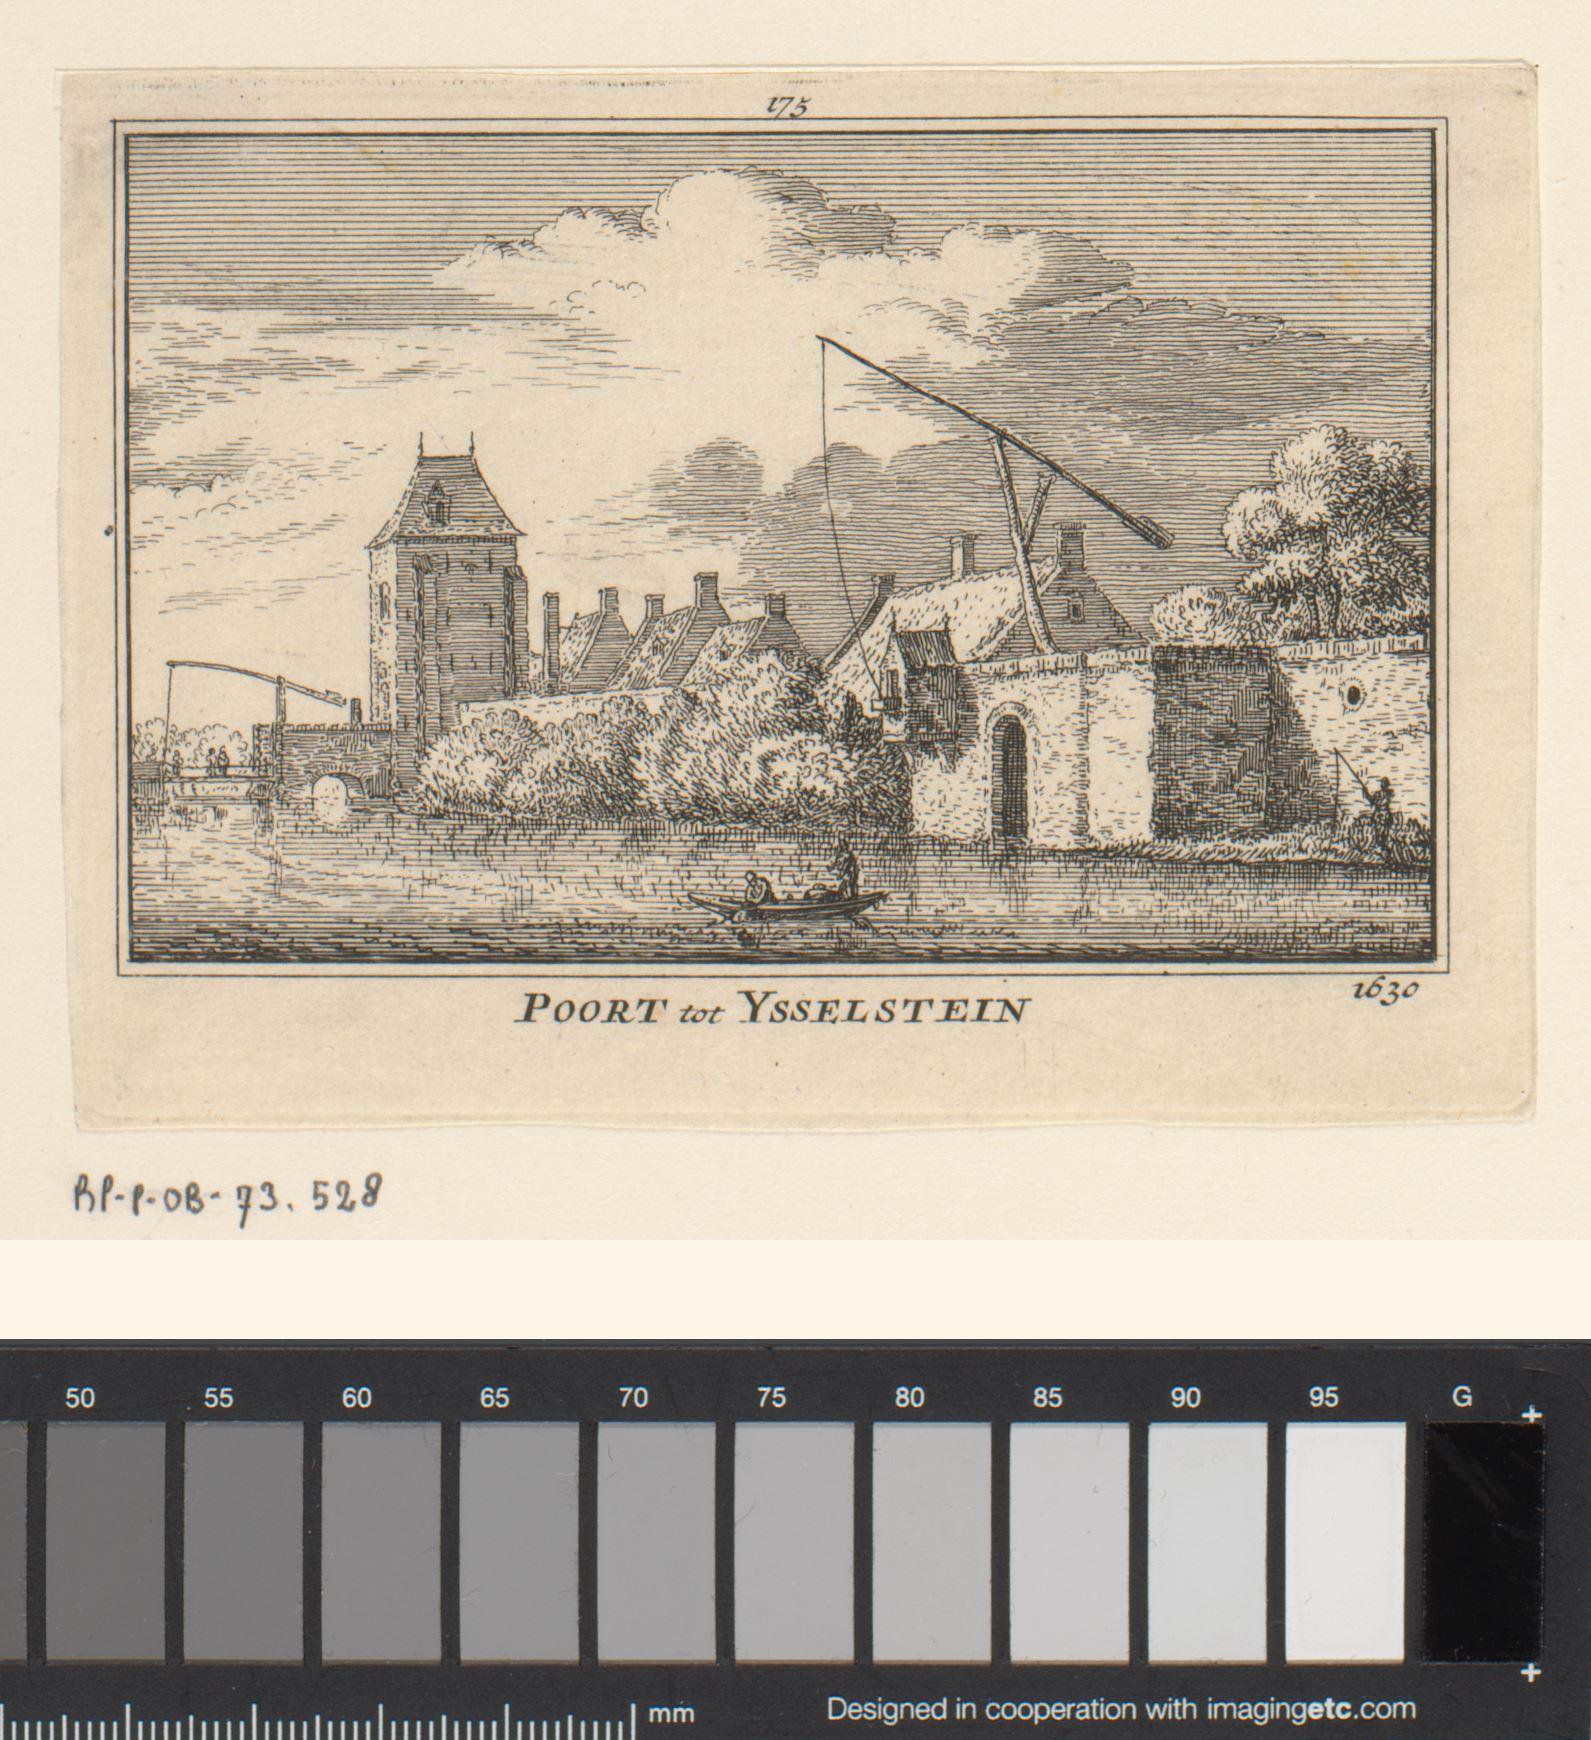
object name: book illustration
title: Gezicht op de IJsselpoort te IJsselstein, 1630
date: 1727-1733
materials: paper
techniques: etching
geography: amsterdam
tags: rowing-boat, canoe, etc., bridge, city-gate, fisherman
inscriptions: collector's mark: Lugt 2228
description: Illustratie uit: Abraham Rademaker, Matthaeus Brouërius van Niedek, Isaac Le Long, Kabinet van Nederlandsche en Kleefsche outheden en (...) voorname stads- en landgebouwen, Willem Barents en Antoni Schoonenburg: Amsterdam, 1727-1733, ill. nr. 175.